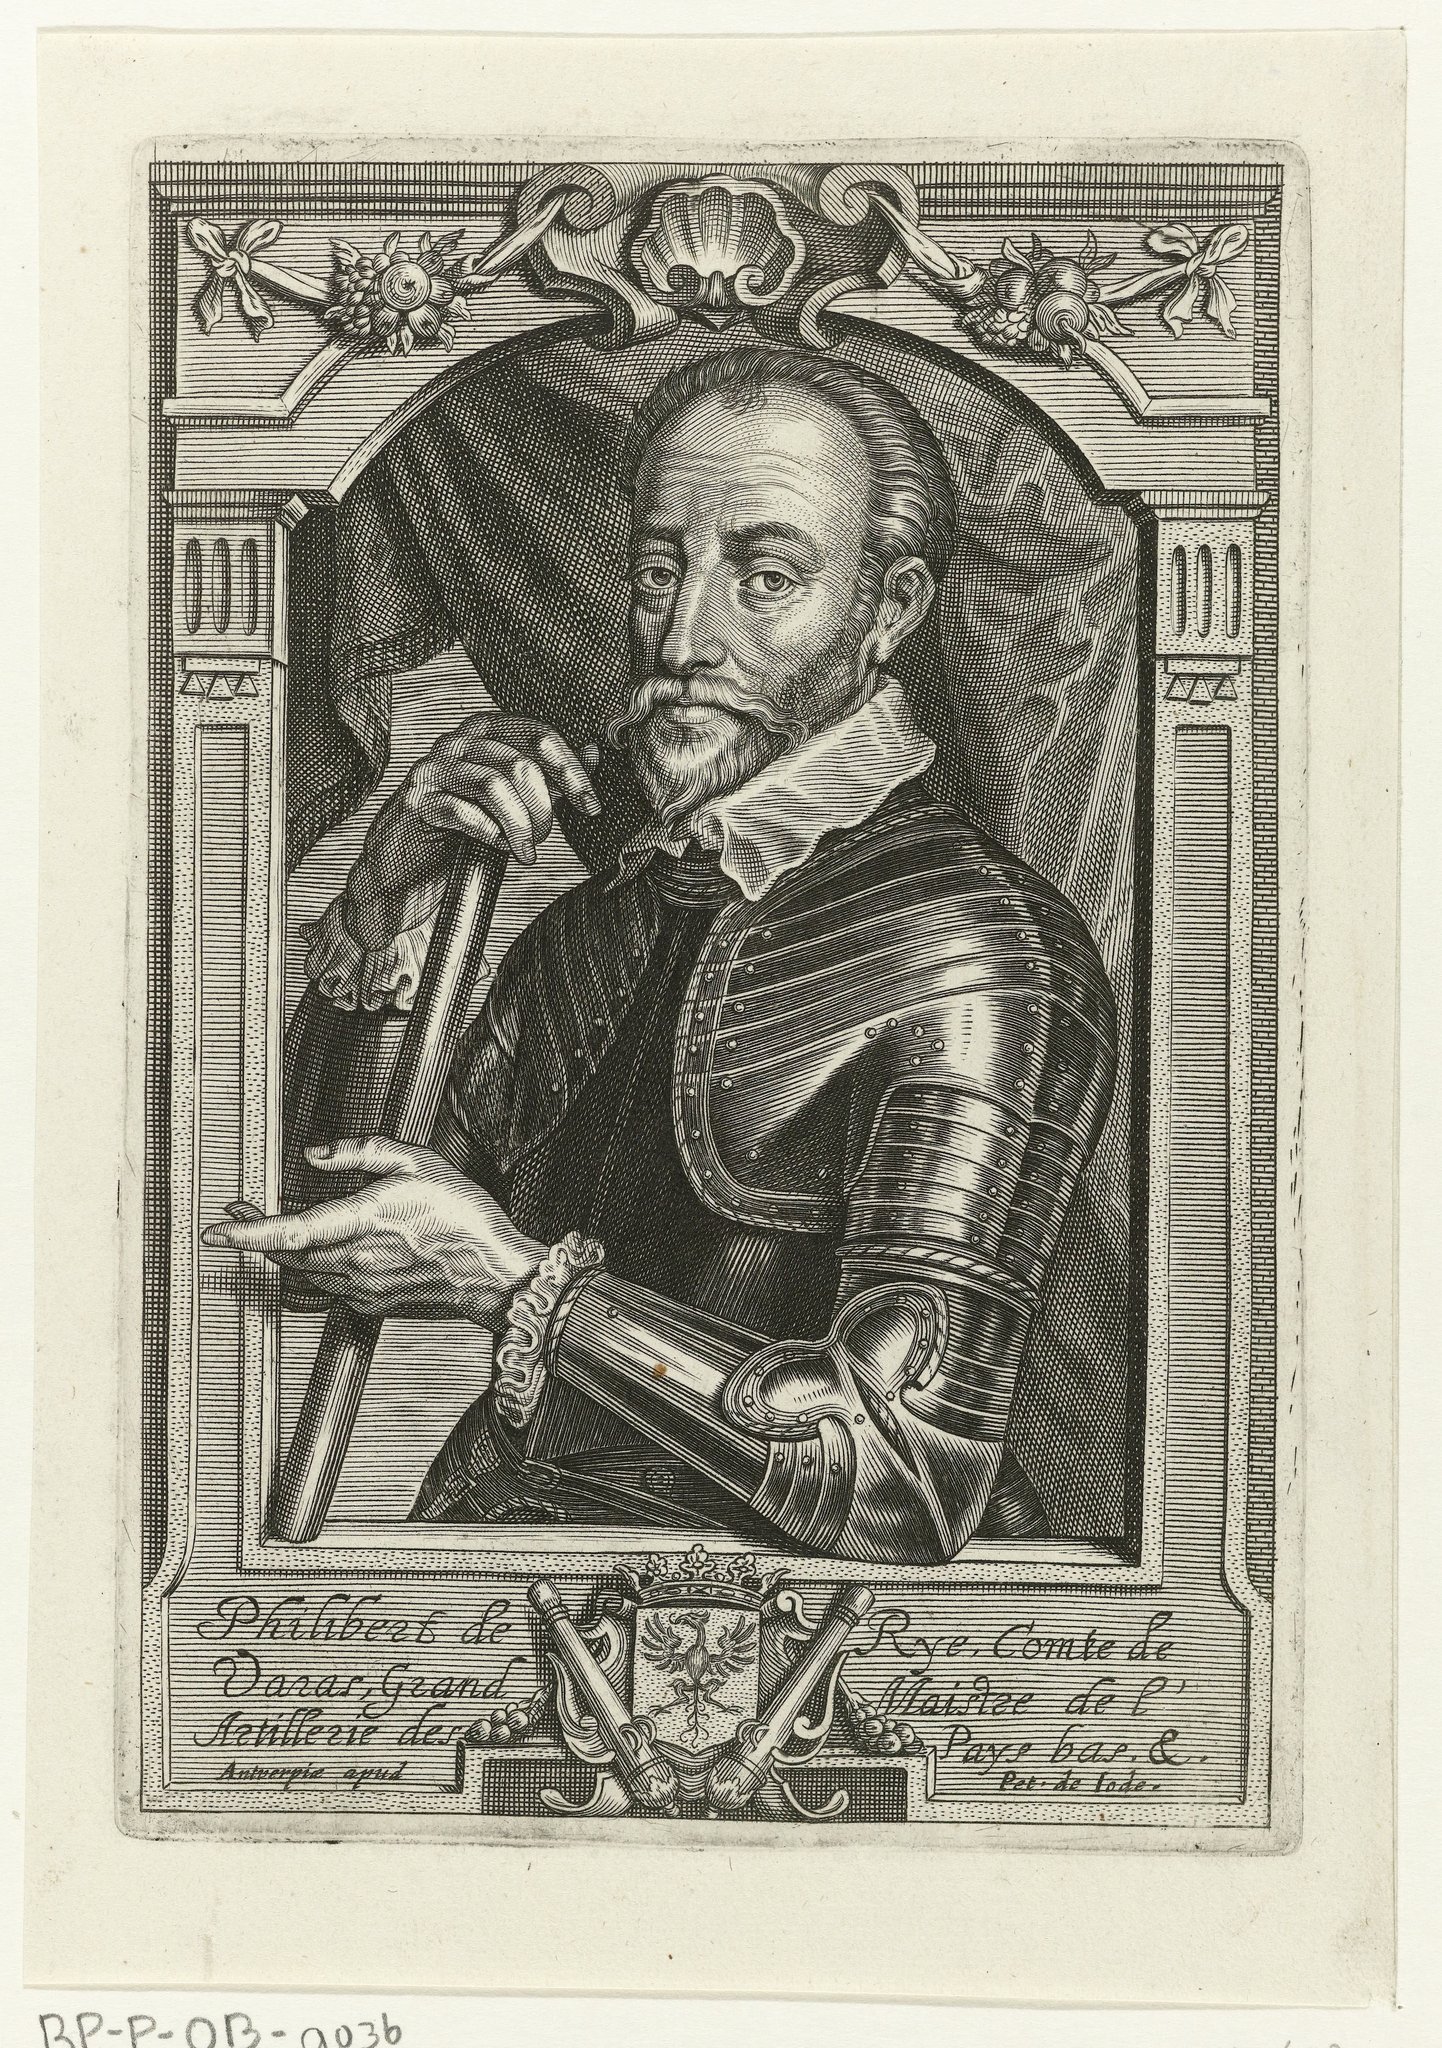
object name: print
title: Theatrum pontificum, imperatorum, regum, ducum, principum, etc.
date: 1628-1670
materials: paper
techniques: engraving, etching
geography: antwerp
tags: armour, baton of general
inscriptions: collector's mark: Lugt 2228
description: Portret van Philibert de Rye, ten halven lijve. Hij draagt een harnas en in zijn rechterhand houdt hij een commandostaf. Met zijn linkerarm leunt hij op de omlijsting. Het portret is gevat in een boogvormige, ornamentele omlijsting met het wapenschild van de geportretteerde en een drieregelig onderschrift in het Frans.